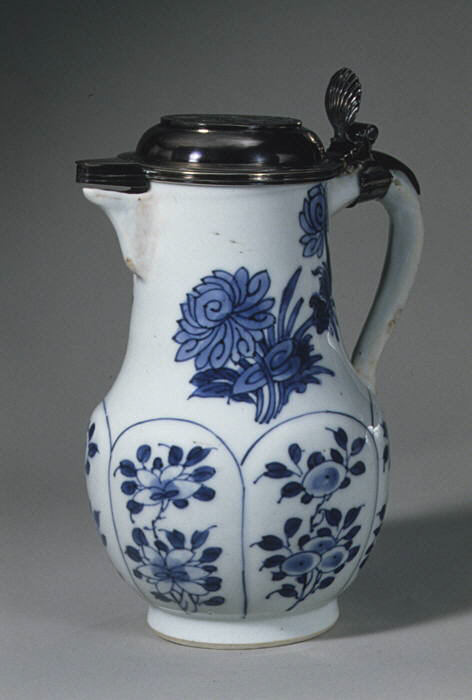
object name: ewer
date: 1701-1733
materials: hard paste porcelain, silver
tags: flowers